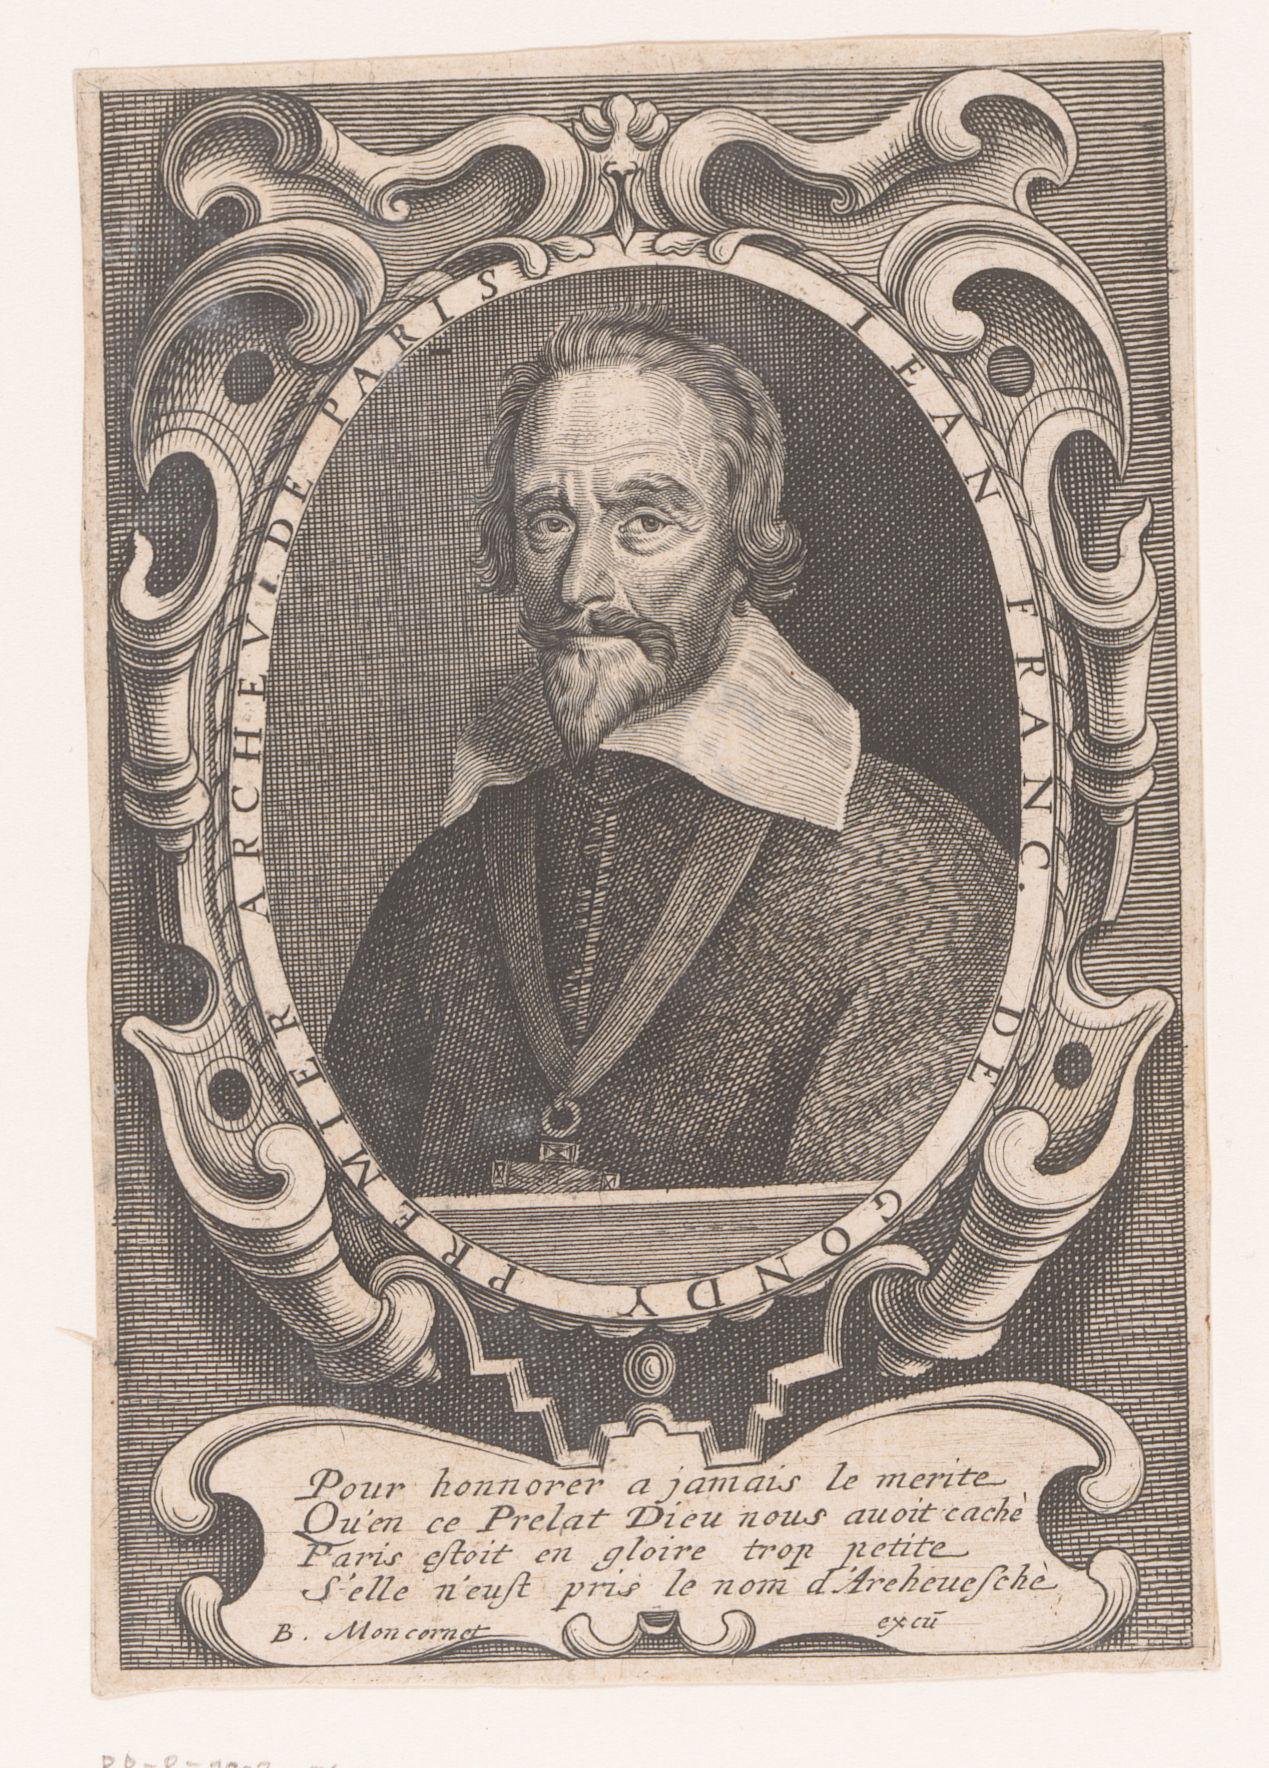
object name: print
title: Portret van Jean-François de Gondi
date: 1634-1668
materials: paper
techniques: engraving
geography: paris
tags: paris, archbishop, bishop, etc. (roman catholic), historical persons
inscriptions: collector's mark: Lugt 2228